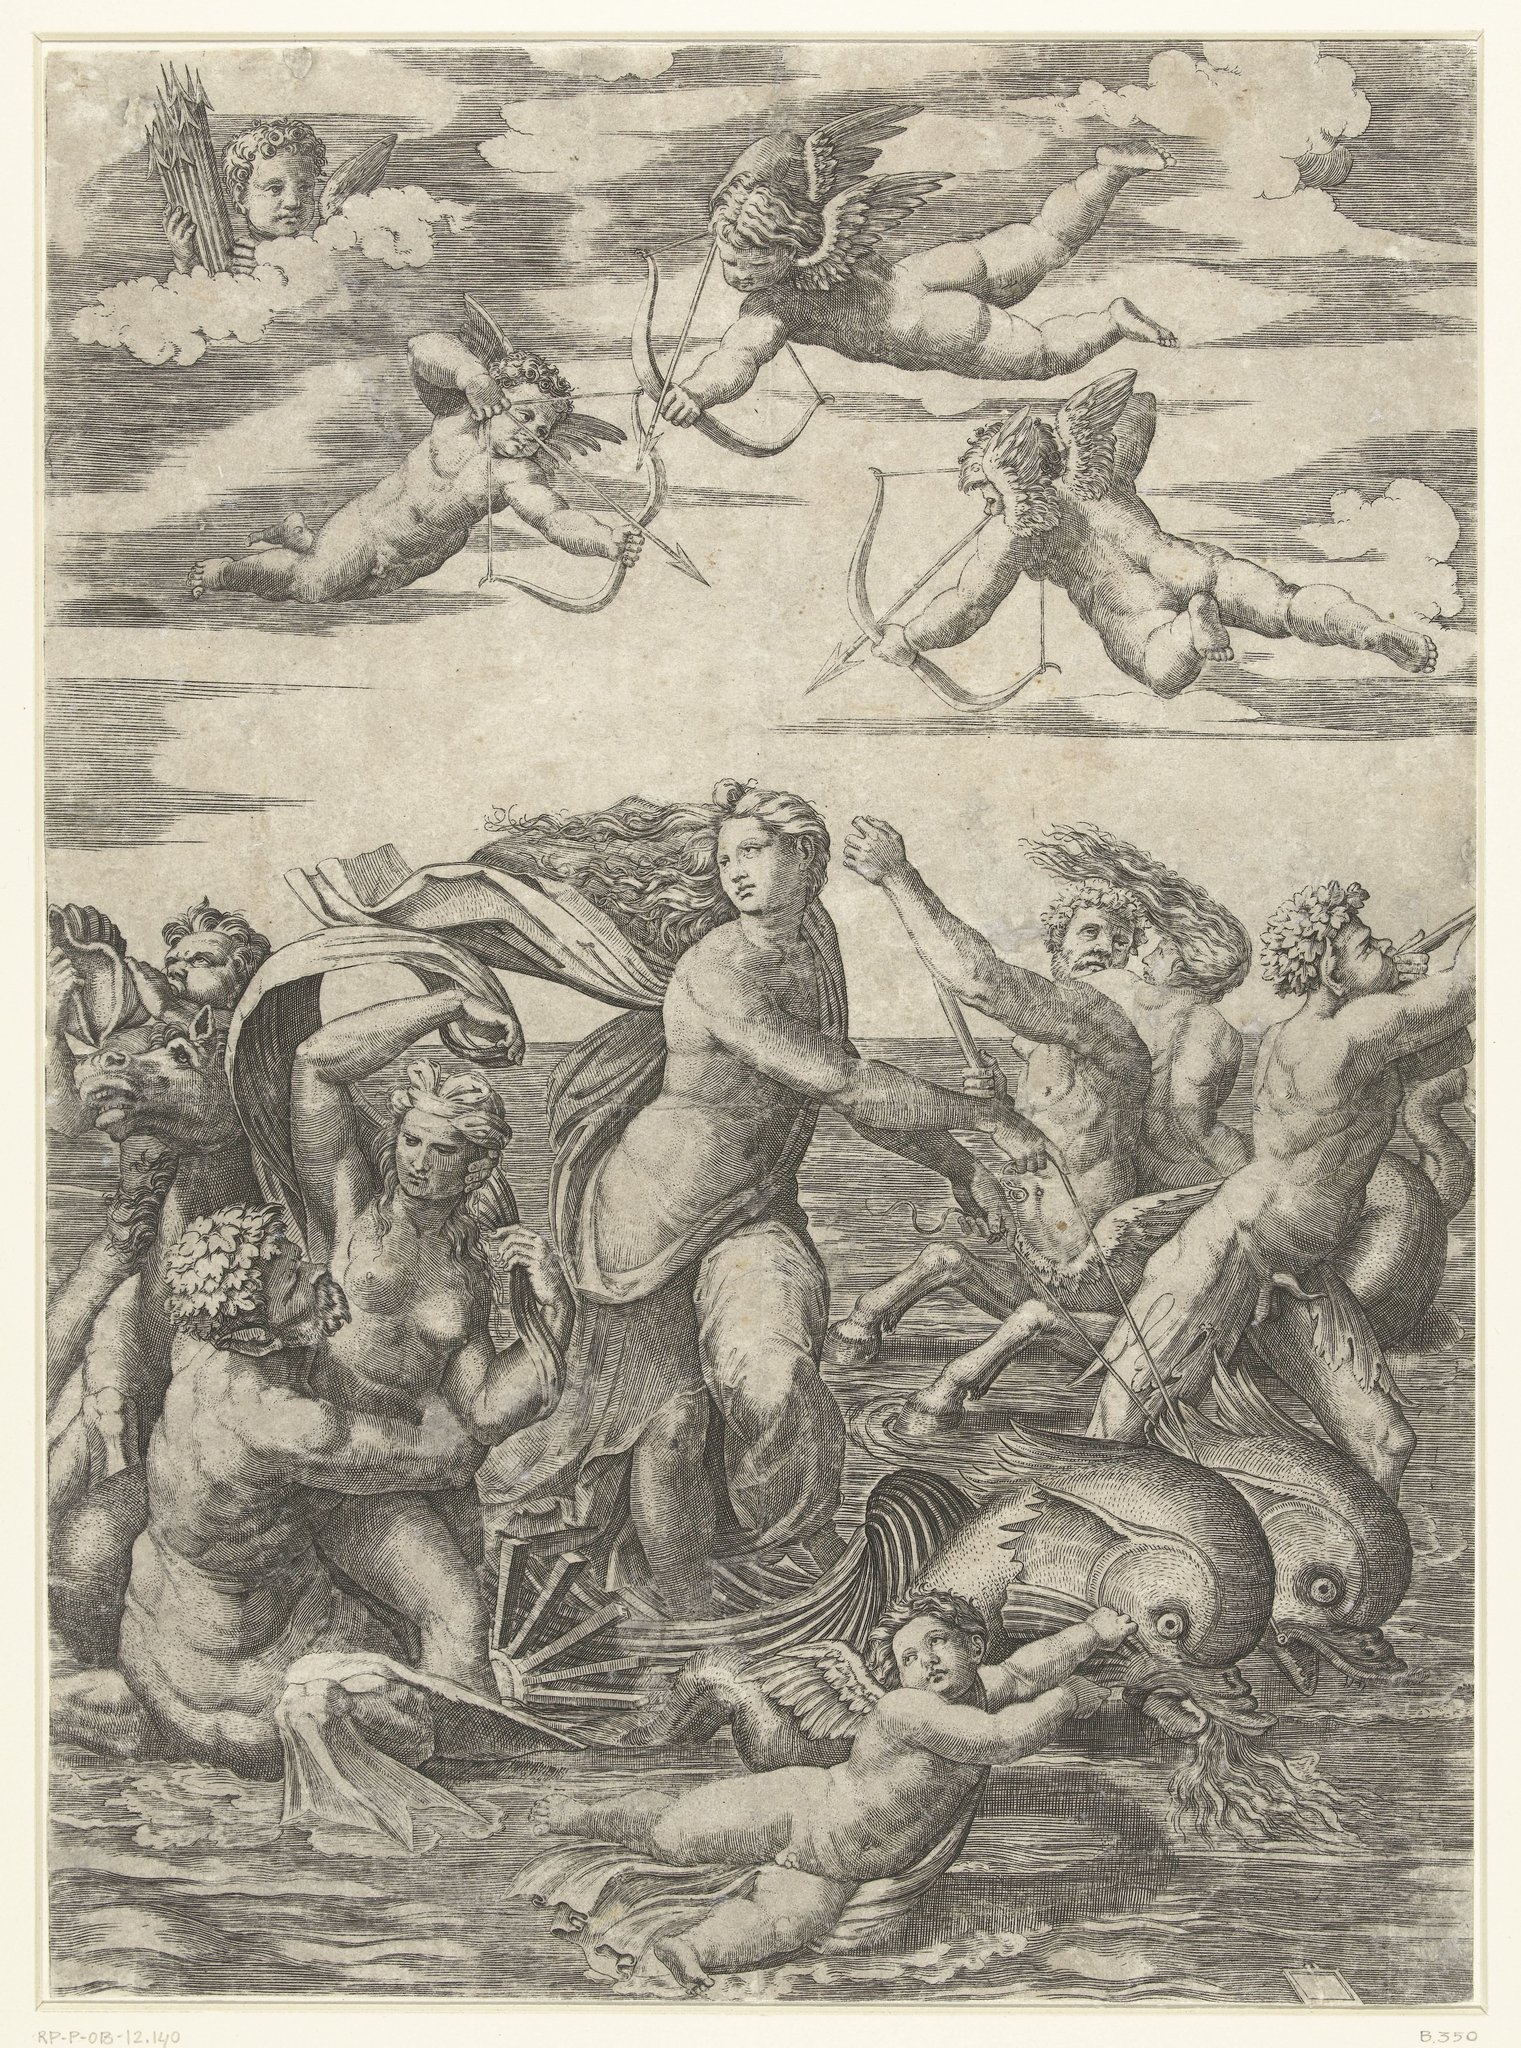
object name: print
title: Triomf van Galatea met tritons en nereïden en putti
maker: marcantonio raimondi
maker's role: print maker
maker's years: 1470-1534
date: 1515-1516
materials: paper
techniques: engraving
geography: italy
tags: triumph of galatea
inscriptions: collector's mark: Lugt 240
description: Galatea staat op een schelp en wordt voortgetrokken door dolfijnen. Zij wordt omringd door tritons en nereïden. Drie putti richten hun pijlen op Galatea.